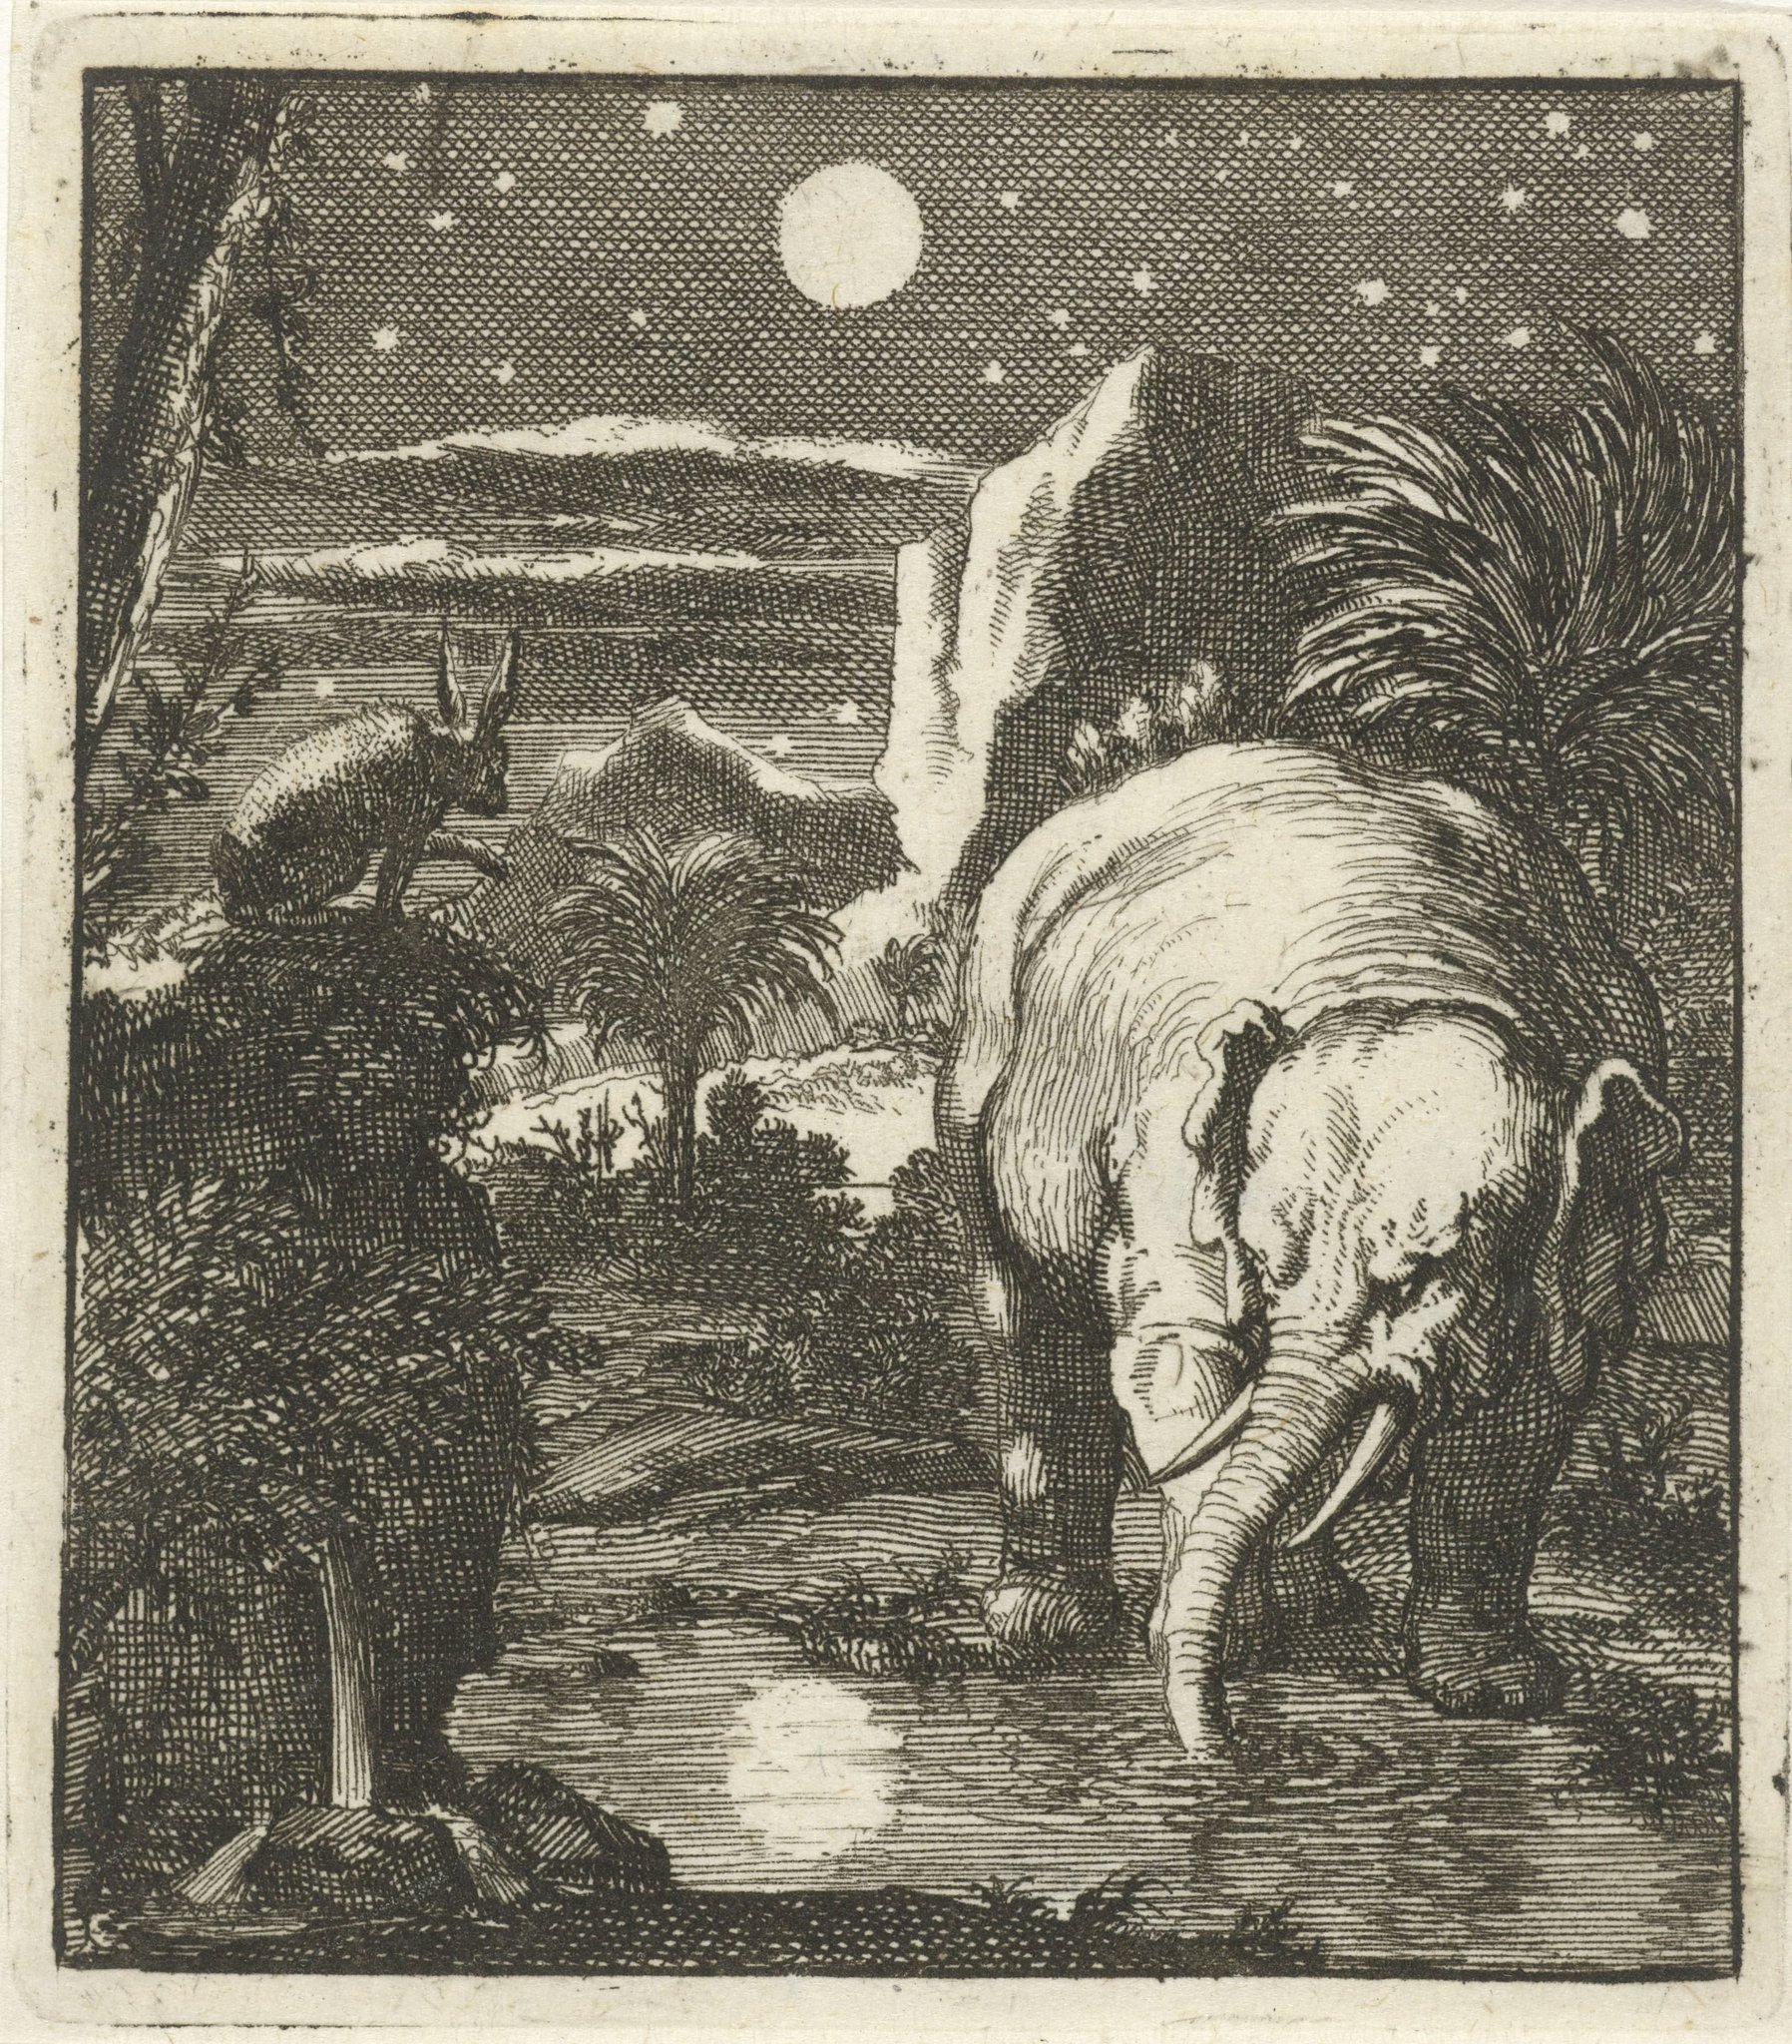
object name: print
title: Haas en olifant met volle maan bij een waterbron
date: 1693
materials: paper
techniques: etching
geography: amsterdam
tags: full moon, rodents: hare, spring (fluids extracted from the earth), trunked animals: elephant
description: Illustratie uit: Duĳkerius, Johannes. Voorbeeldzels der oude wyzen. Waar in (...) de menschelijke hartstogten (...) behandeld worden. Amsterdam: Aart Wolsgrein, 1693, p. 281.